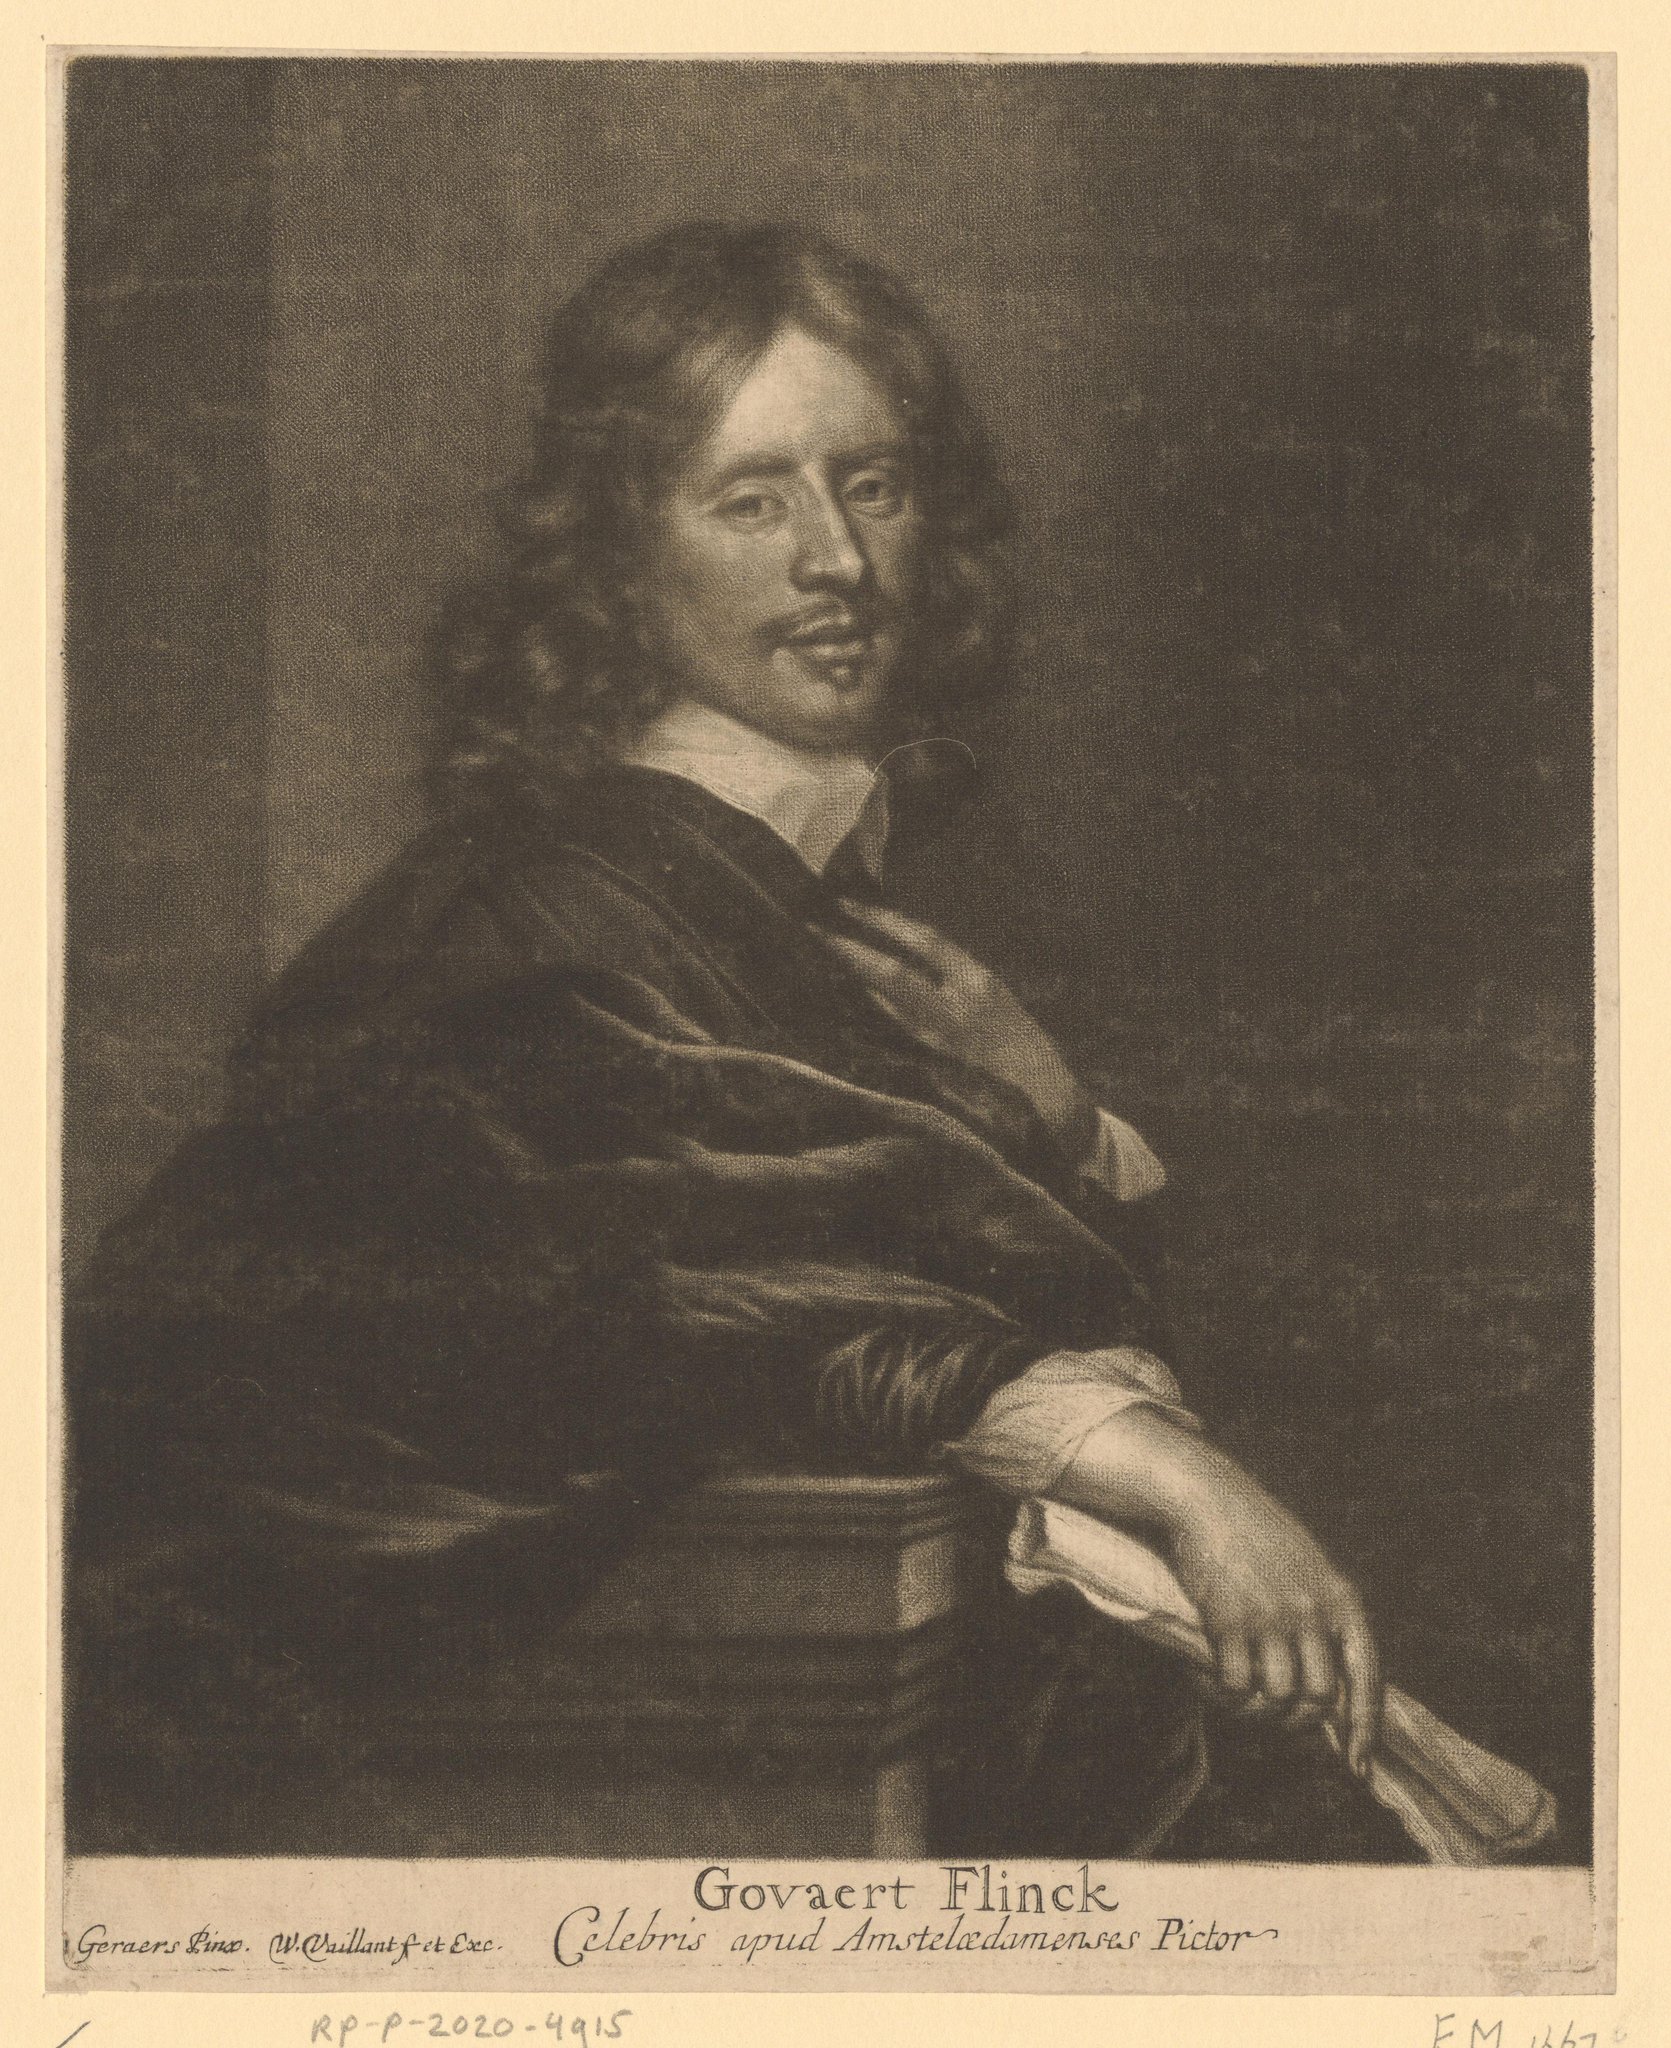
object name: print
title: Portret van Govert Flinck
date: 1671-1673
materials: paper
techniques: mezzotint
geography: northern netherlands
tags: cleves, amsterdam, draughtsman, govert flinck, historical persons, portrait, self-portrait of painter